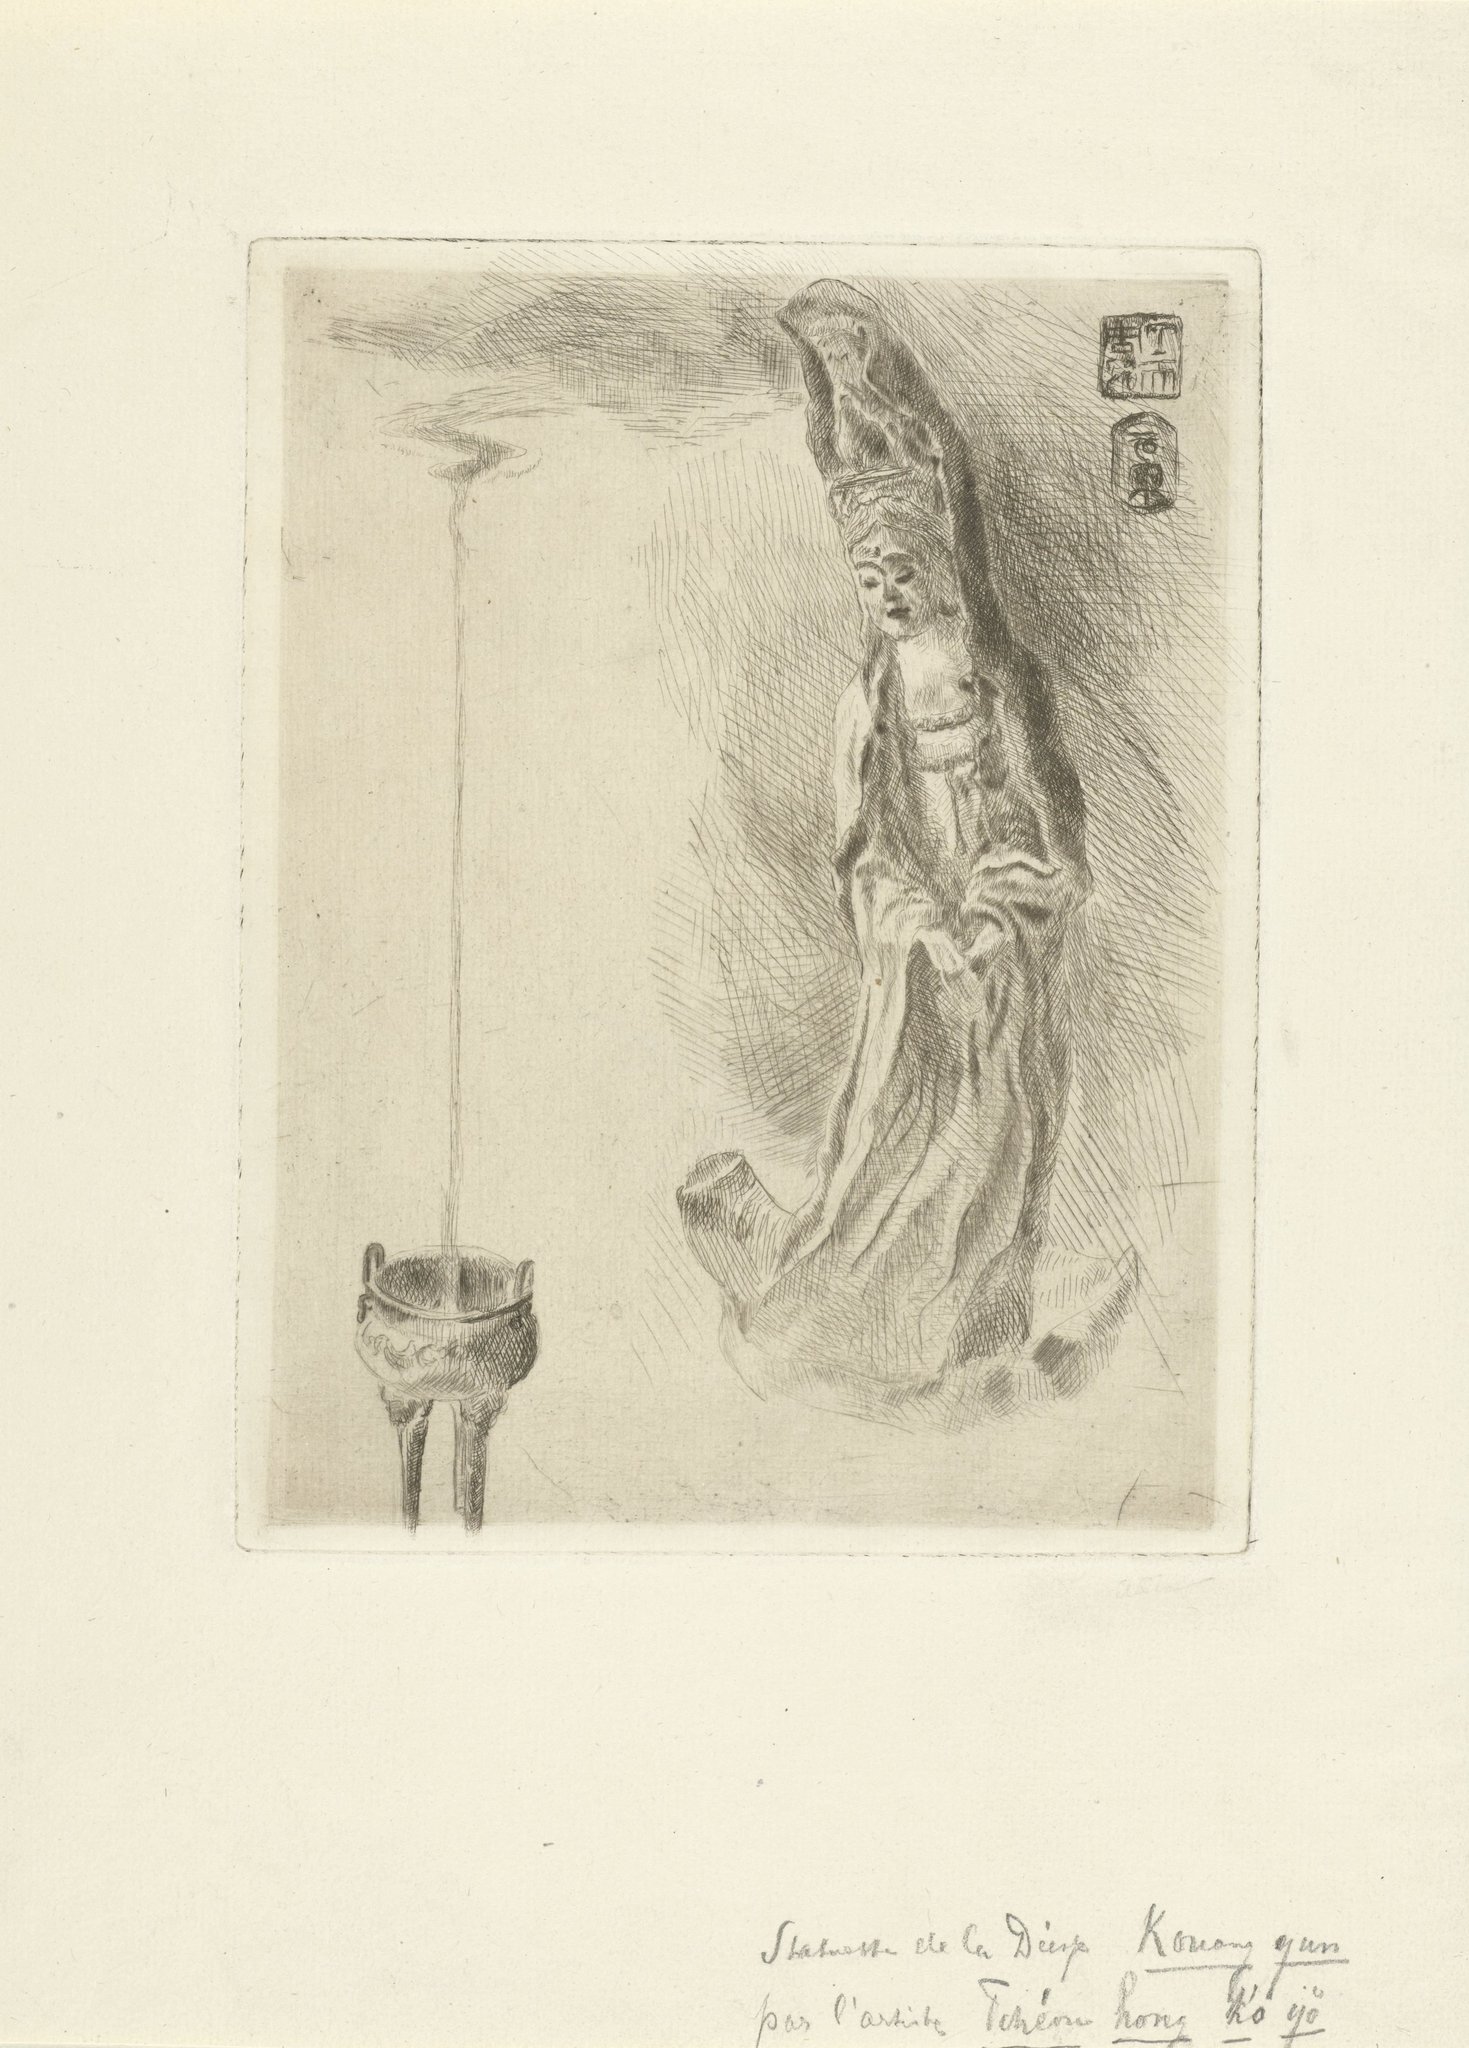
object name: print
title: Standbeeld van een Japanse godin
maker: adriaan pit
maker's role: print maker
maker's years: 1860-1944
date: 1870-1896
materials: paper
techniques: drypoint, etching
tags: piece of sculpture, reproduction of a piece of sculpture, japanese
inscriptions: collector's mark: Lugt 2228, inscription: ‘Statuette de la Déesse Konang Yun par l'artiste Tchéou-Long-Koyó’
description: Standbeeld van een Japanse godin. Rechtsboven twee Japanse tekens. Links op de voorgrond een wierookvat.